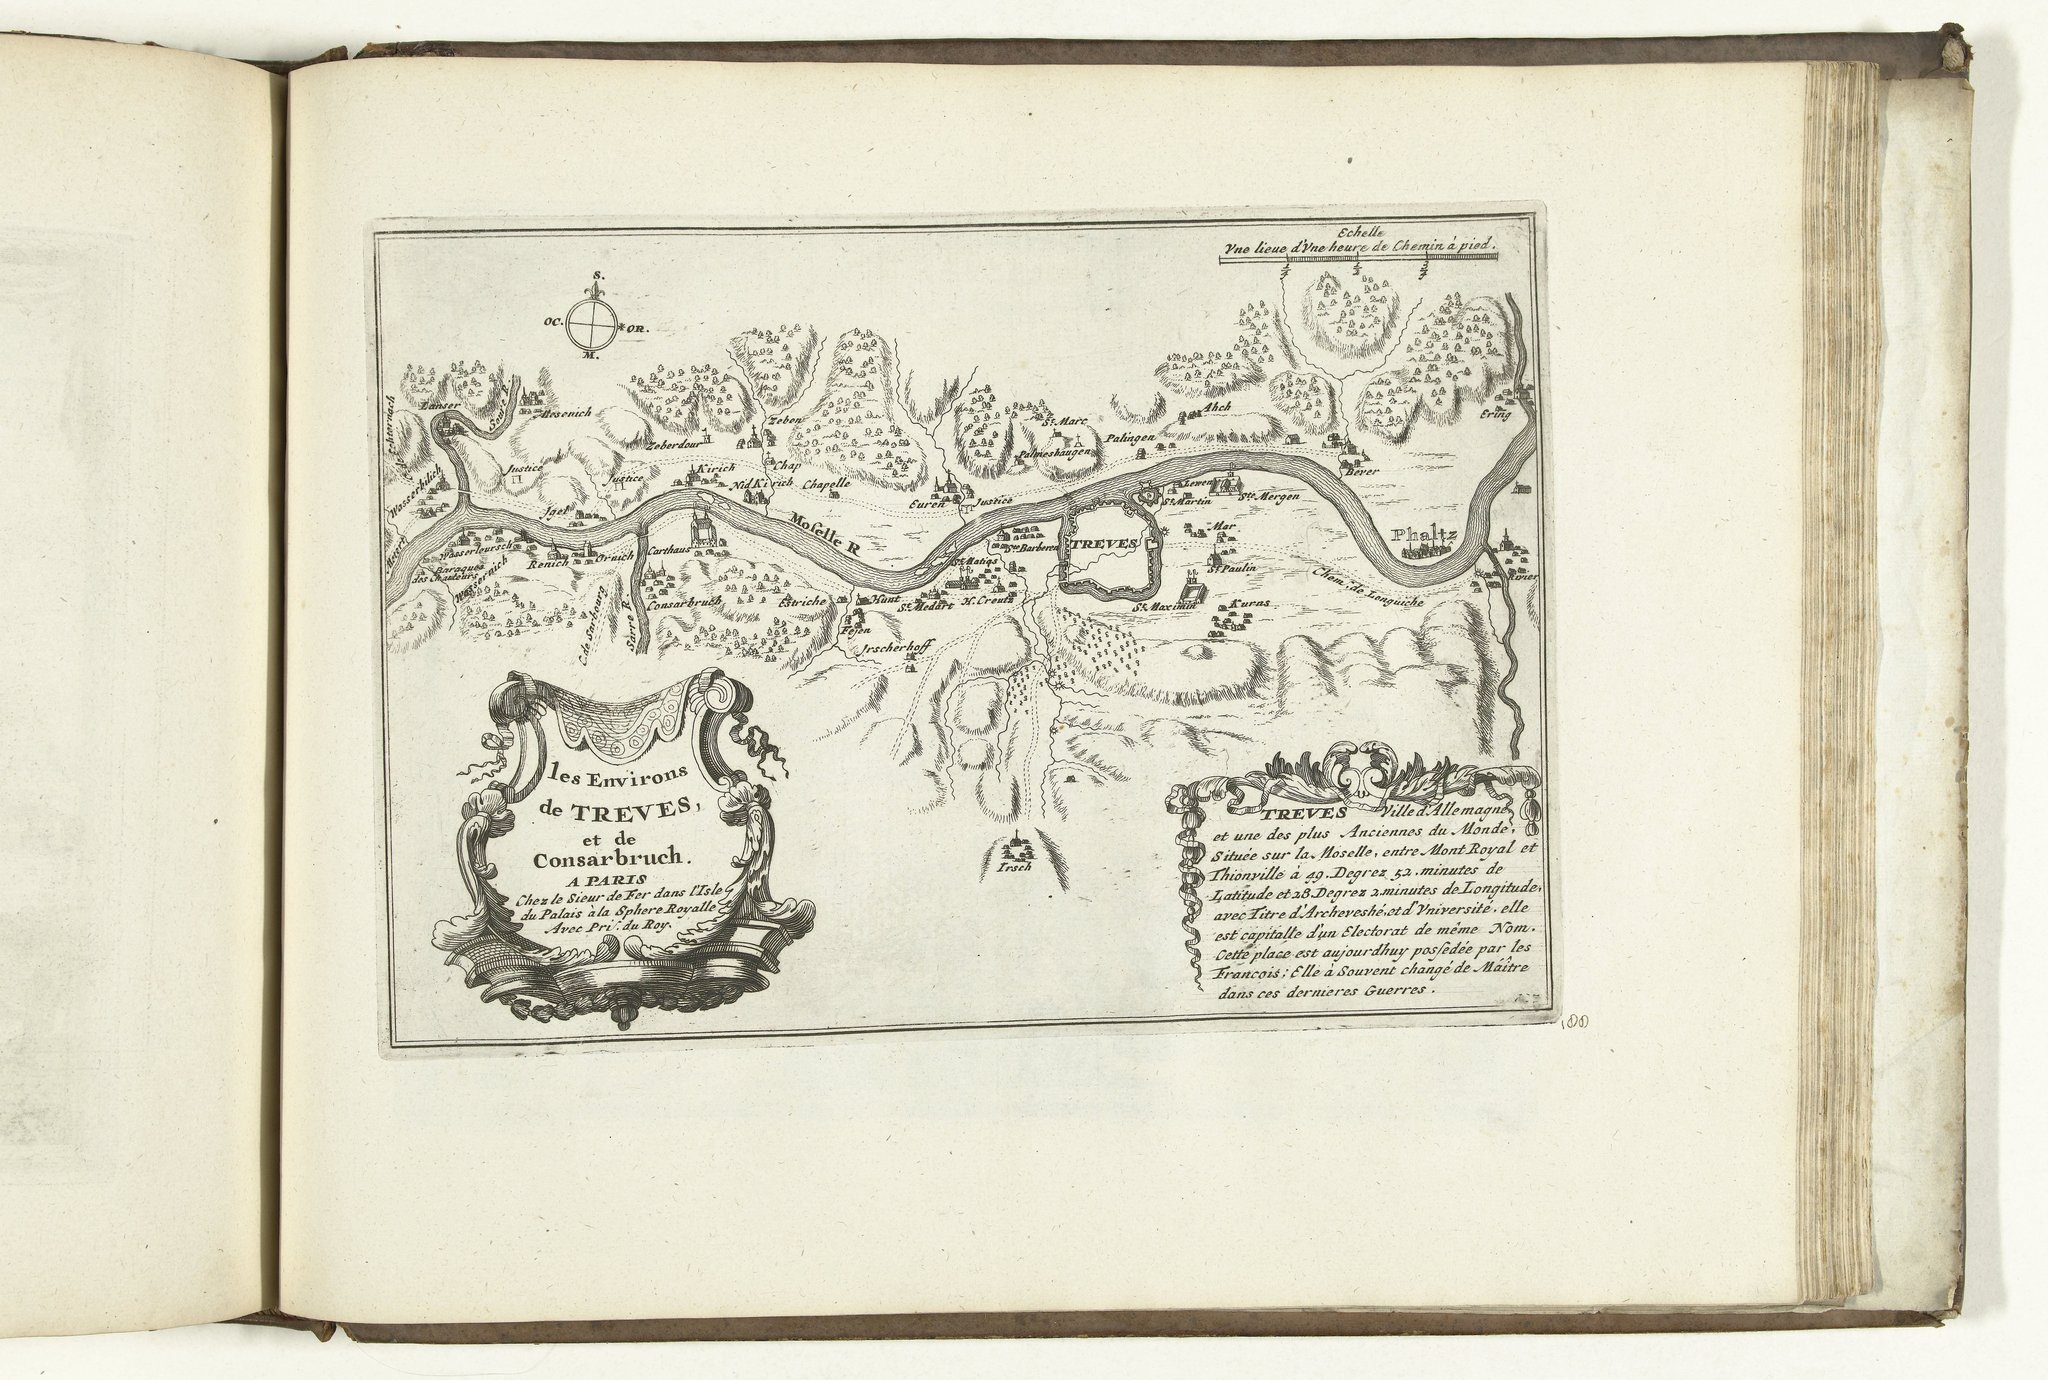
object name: print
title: Les Forces de l'Europe, Asie, Afrique et Amerique (...) Comme aussi les Cartes des Côtes de France et d'Espagne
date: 1726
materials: paper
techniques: etching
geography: paris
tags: maps of separate countries or regions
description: Kaart van de omgeving tussen Trier en Saarburg aan de Mosel. Plaat nr. 188 in deel VIII van het prentwerk: Les Forces de l'Europe, Asie, Afrique et Amerique ... Comme aussi les Cartes des Côtes de France et d'Espagne uit 1726, dit eerste deel met 238 met de hand genummerde platen van vermaarde sterke steden en vestingen in het kader van de Spaanse Successieoorlog 1701-1713. Voor het merendeel zijn deze platen gekopieerd naar de anonieme Franse platen van vermaarde sterke steden en vestingen: in Les forces de l'Europe en in: Le theatre de la guerre, dans les Pays-Bas, beide oorspronkelijk uitgegeven door Nicolas de Fer te Parijs (1693-1697) in het kader van de Negenjarige Oorlog. Titel en opschriften in het Frans. Rechtsonder sporen van het weggepolijste nummer: 127.